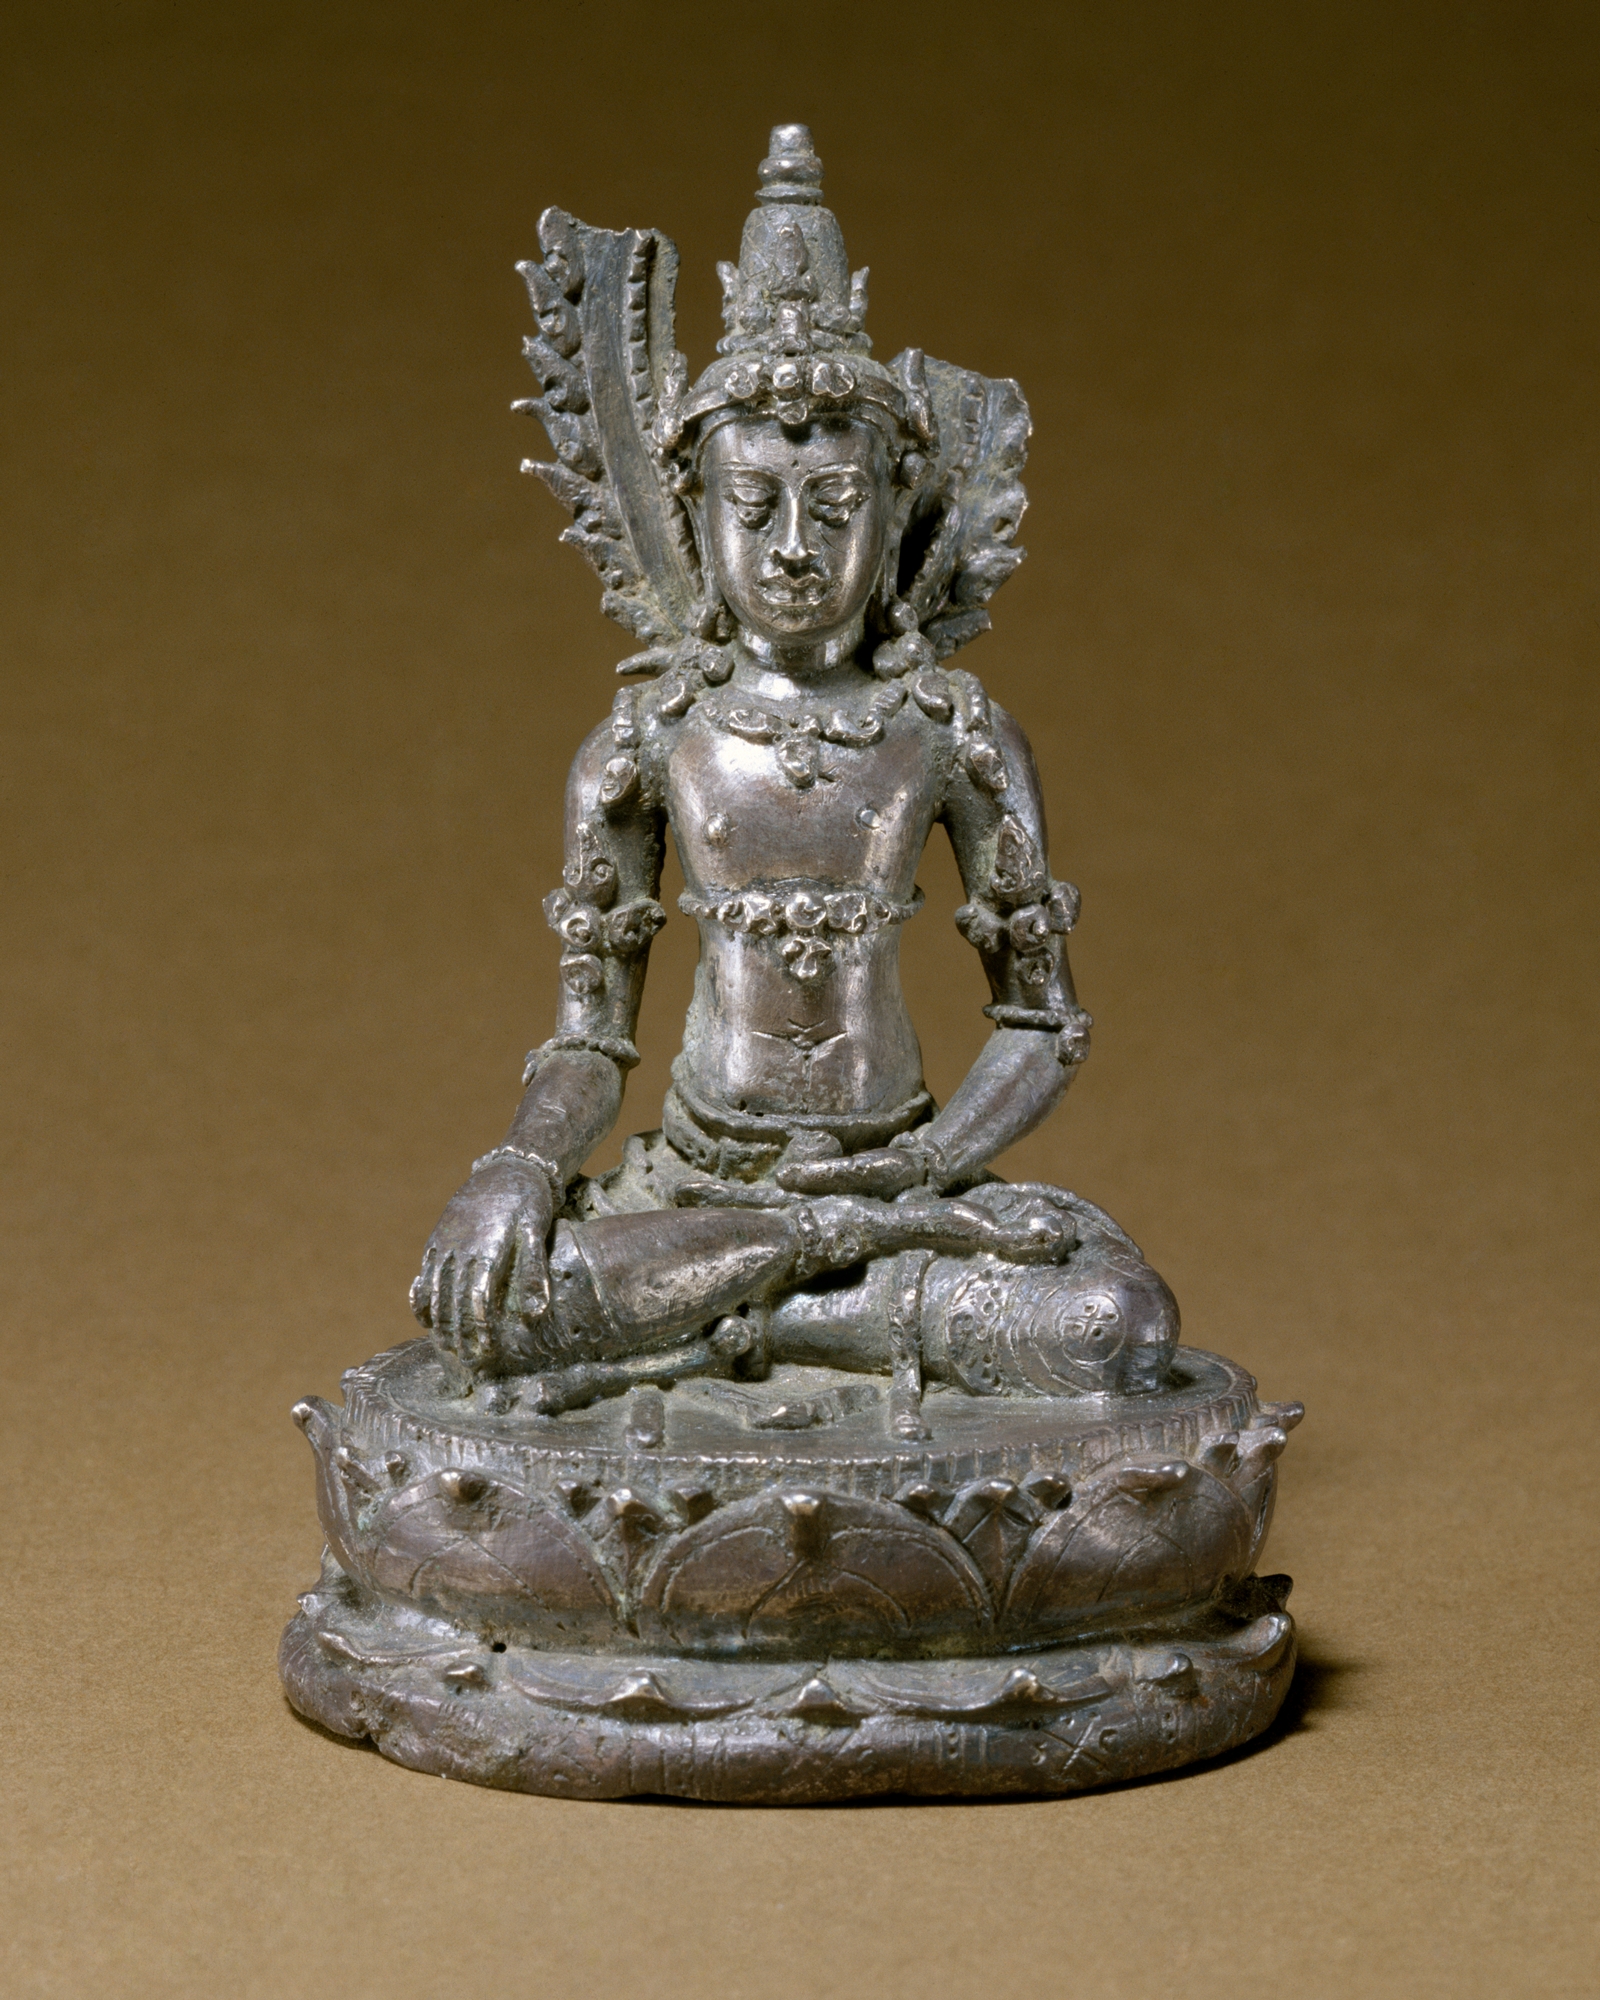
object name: figurine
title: Seated Transcendent Buddha Akshobhya (?)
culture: indonesian, javanese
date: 951-1000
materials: silver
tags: buddhism,akshobhya,buddha